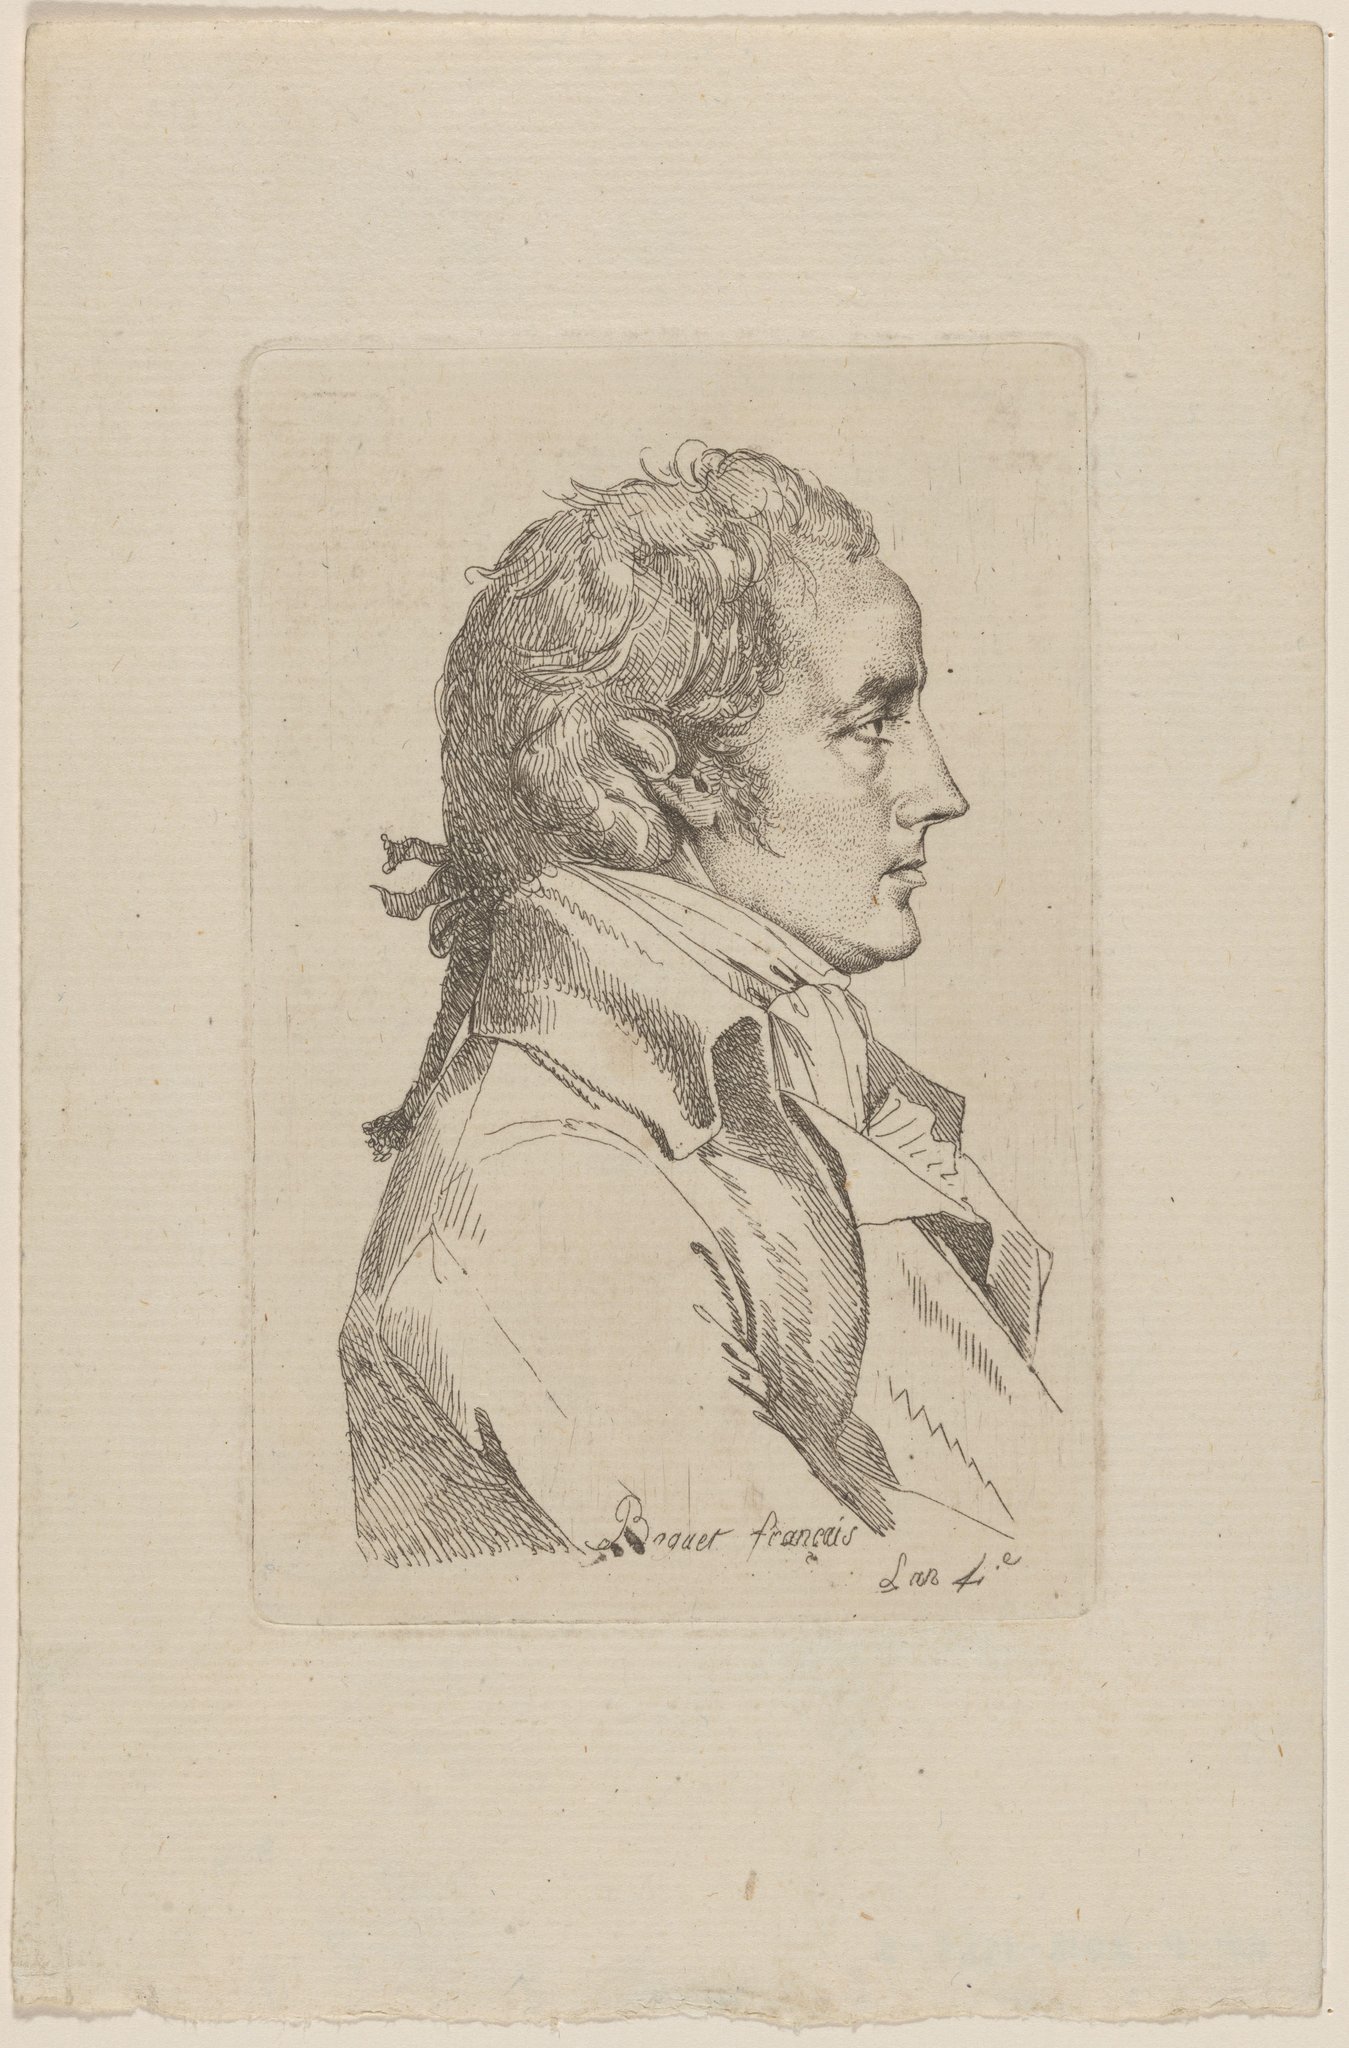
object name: print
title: Portret, mogelijk zelfportret, van landschapsschilder Nicolas Didier Boguet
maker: nicolas didier boguet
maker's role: print maker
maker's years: 1755-1839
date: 1793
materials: paper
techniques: etching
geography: france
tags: rome, nicolas didier boguet, historical persons, portrait, self-portrait of painter, portrait, self-portrait of artist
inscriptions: date: ‘L an 4.e’, collector's mark: Lugt 2228, collector's mark: Lugt 2760